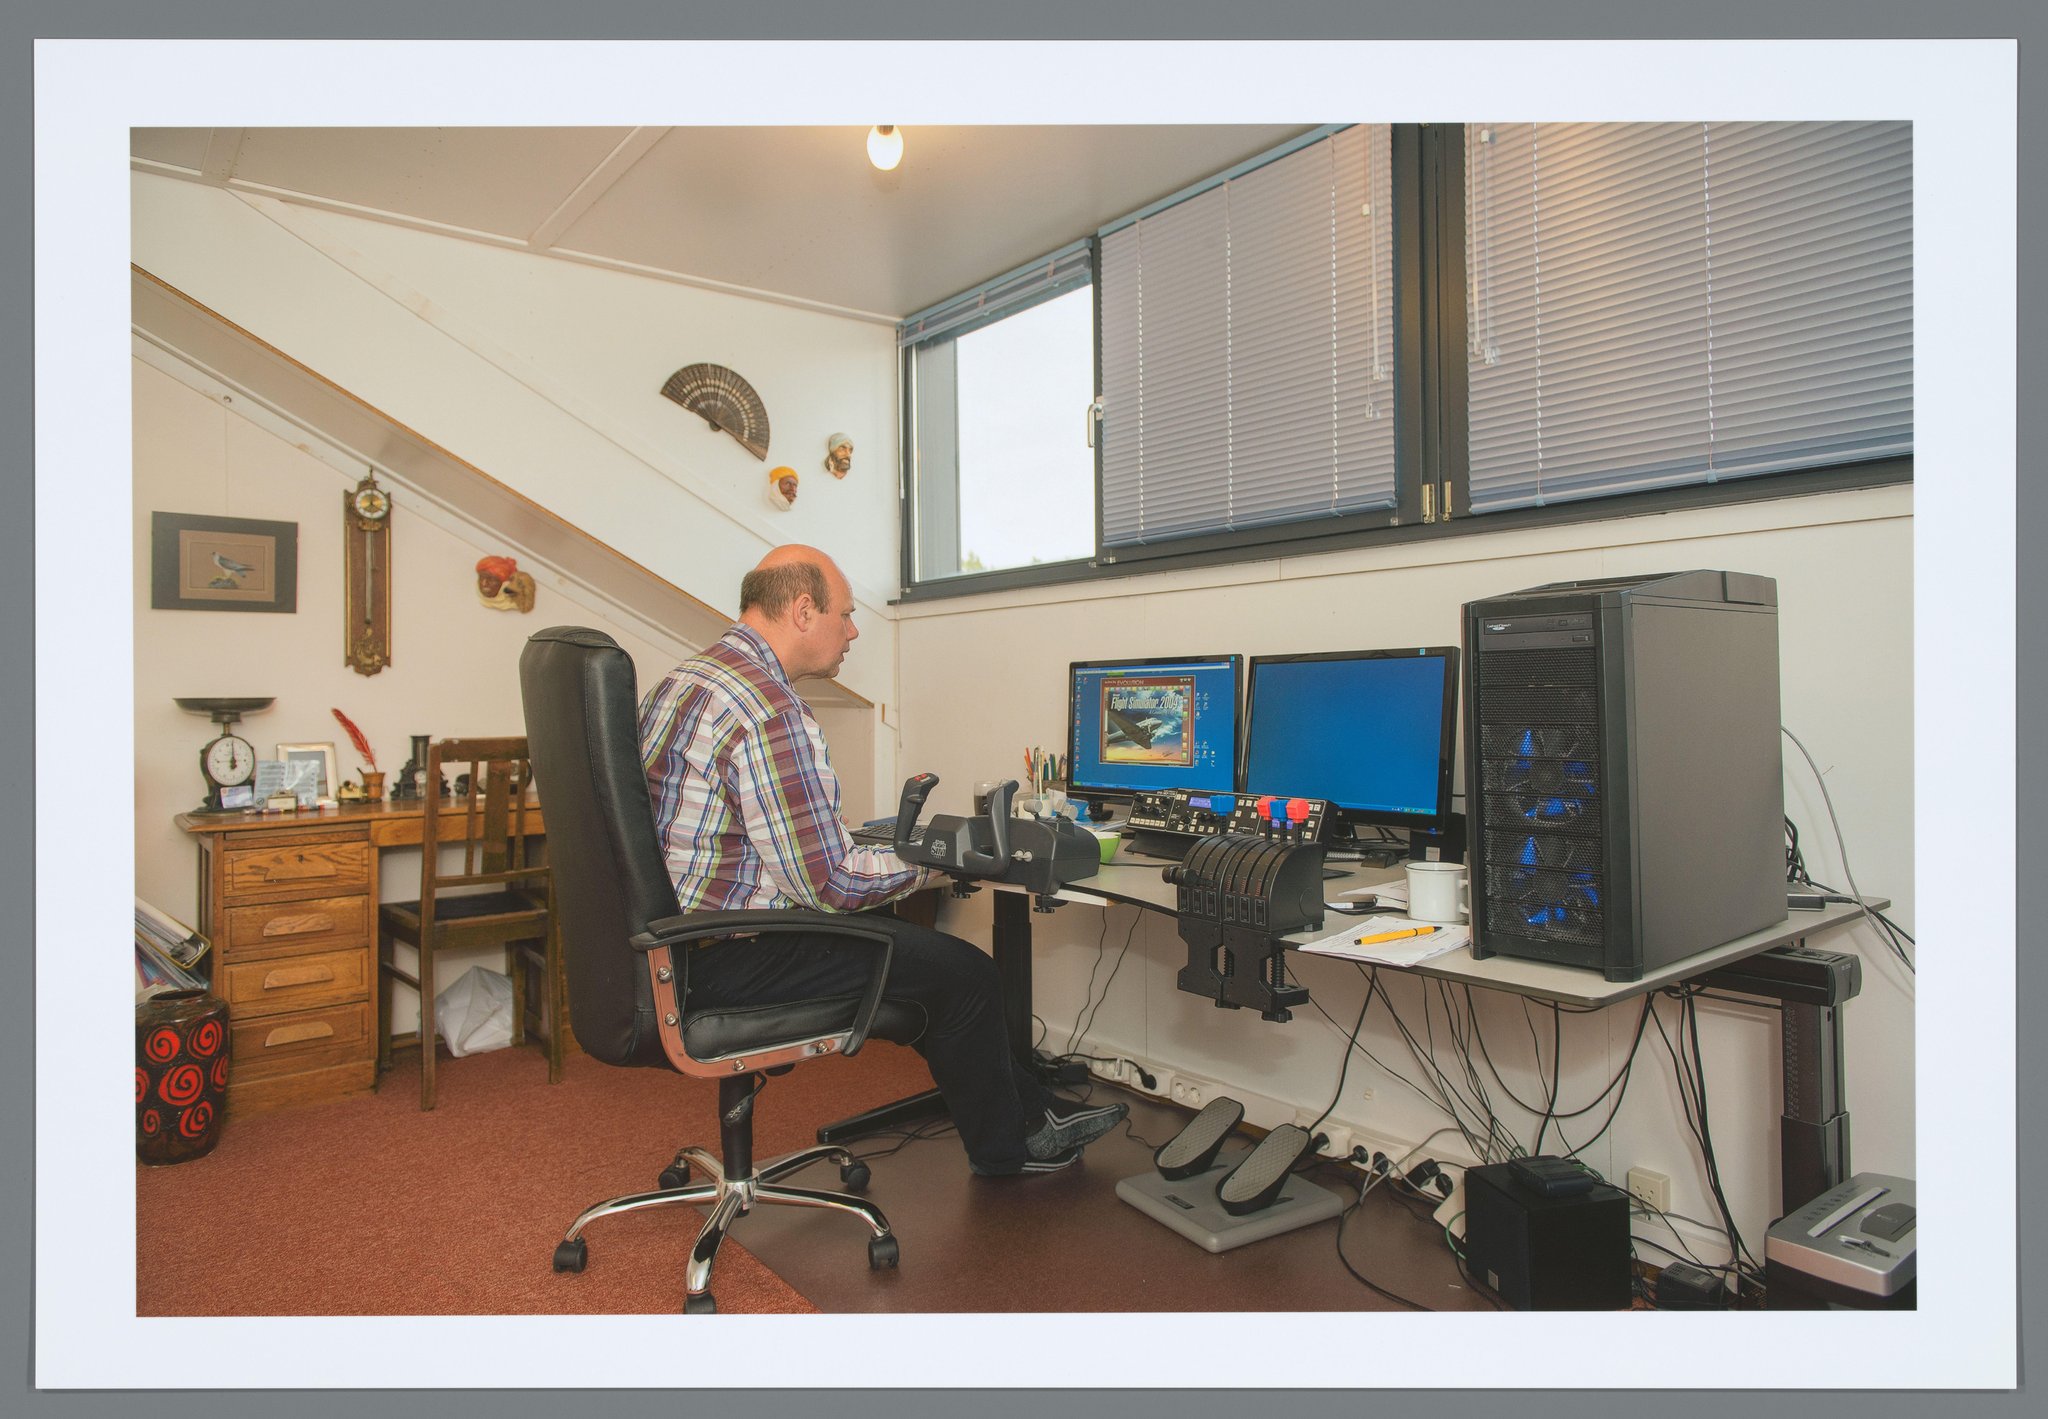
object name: photograph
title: Jurjan (53)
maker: gerrit meerman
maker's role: fotograaf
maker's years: 1957-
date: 2015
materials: ink, paper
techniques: inkjet print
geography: netherlands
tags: airborne traffic, aviation, computer, equation-solving machine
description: “Ik heb al 3x in de full motion simulator op Schiphol mogen vliegen”. Al zeker vijfentwintig jaar geleden is Jurjan begonnen met een eenvoudige versie van Flight Simulator. Tien jaar geleden begon de hobby pas echt serieuze vormen aan te nemen. Hij bestudeerde verschillende boeken (in het Engels) om het vliegen goed onder de knie te krijgen. Hij leerde goed navigeren en vliegen op een 737-800 bij ProSim4U en in de professionele full motion simulator op Schiphol onder leiding van een echte gezagvoerder. Hij is ongeveer vier keer per week met zijn hobby bezig en is lid van KLM Virtual Airlines. Minimaal één keer per maand moet hij online een bestaande KLM- vlucht maken.